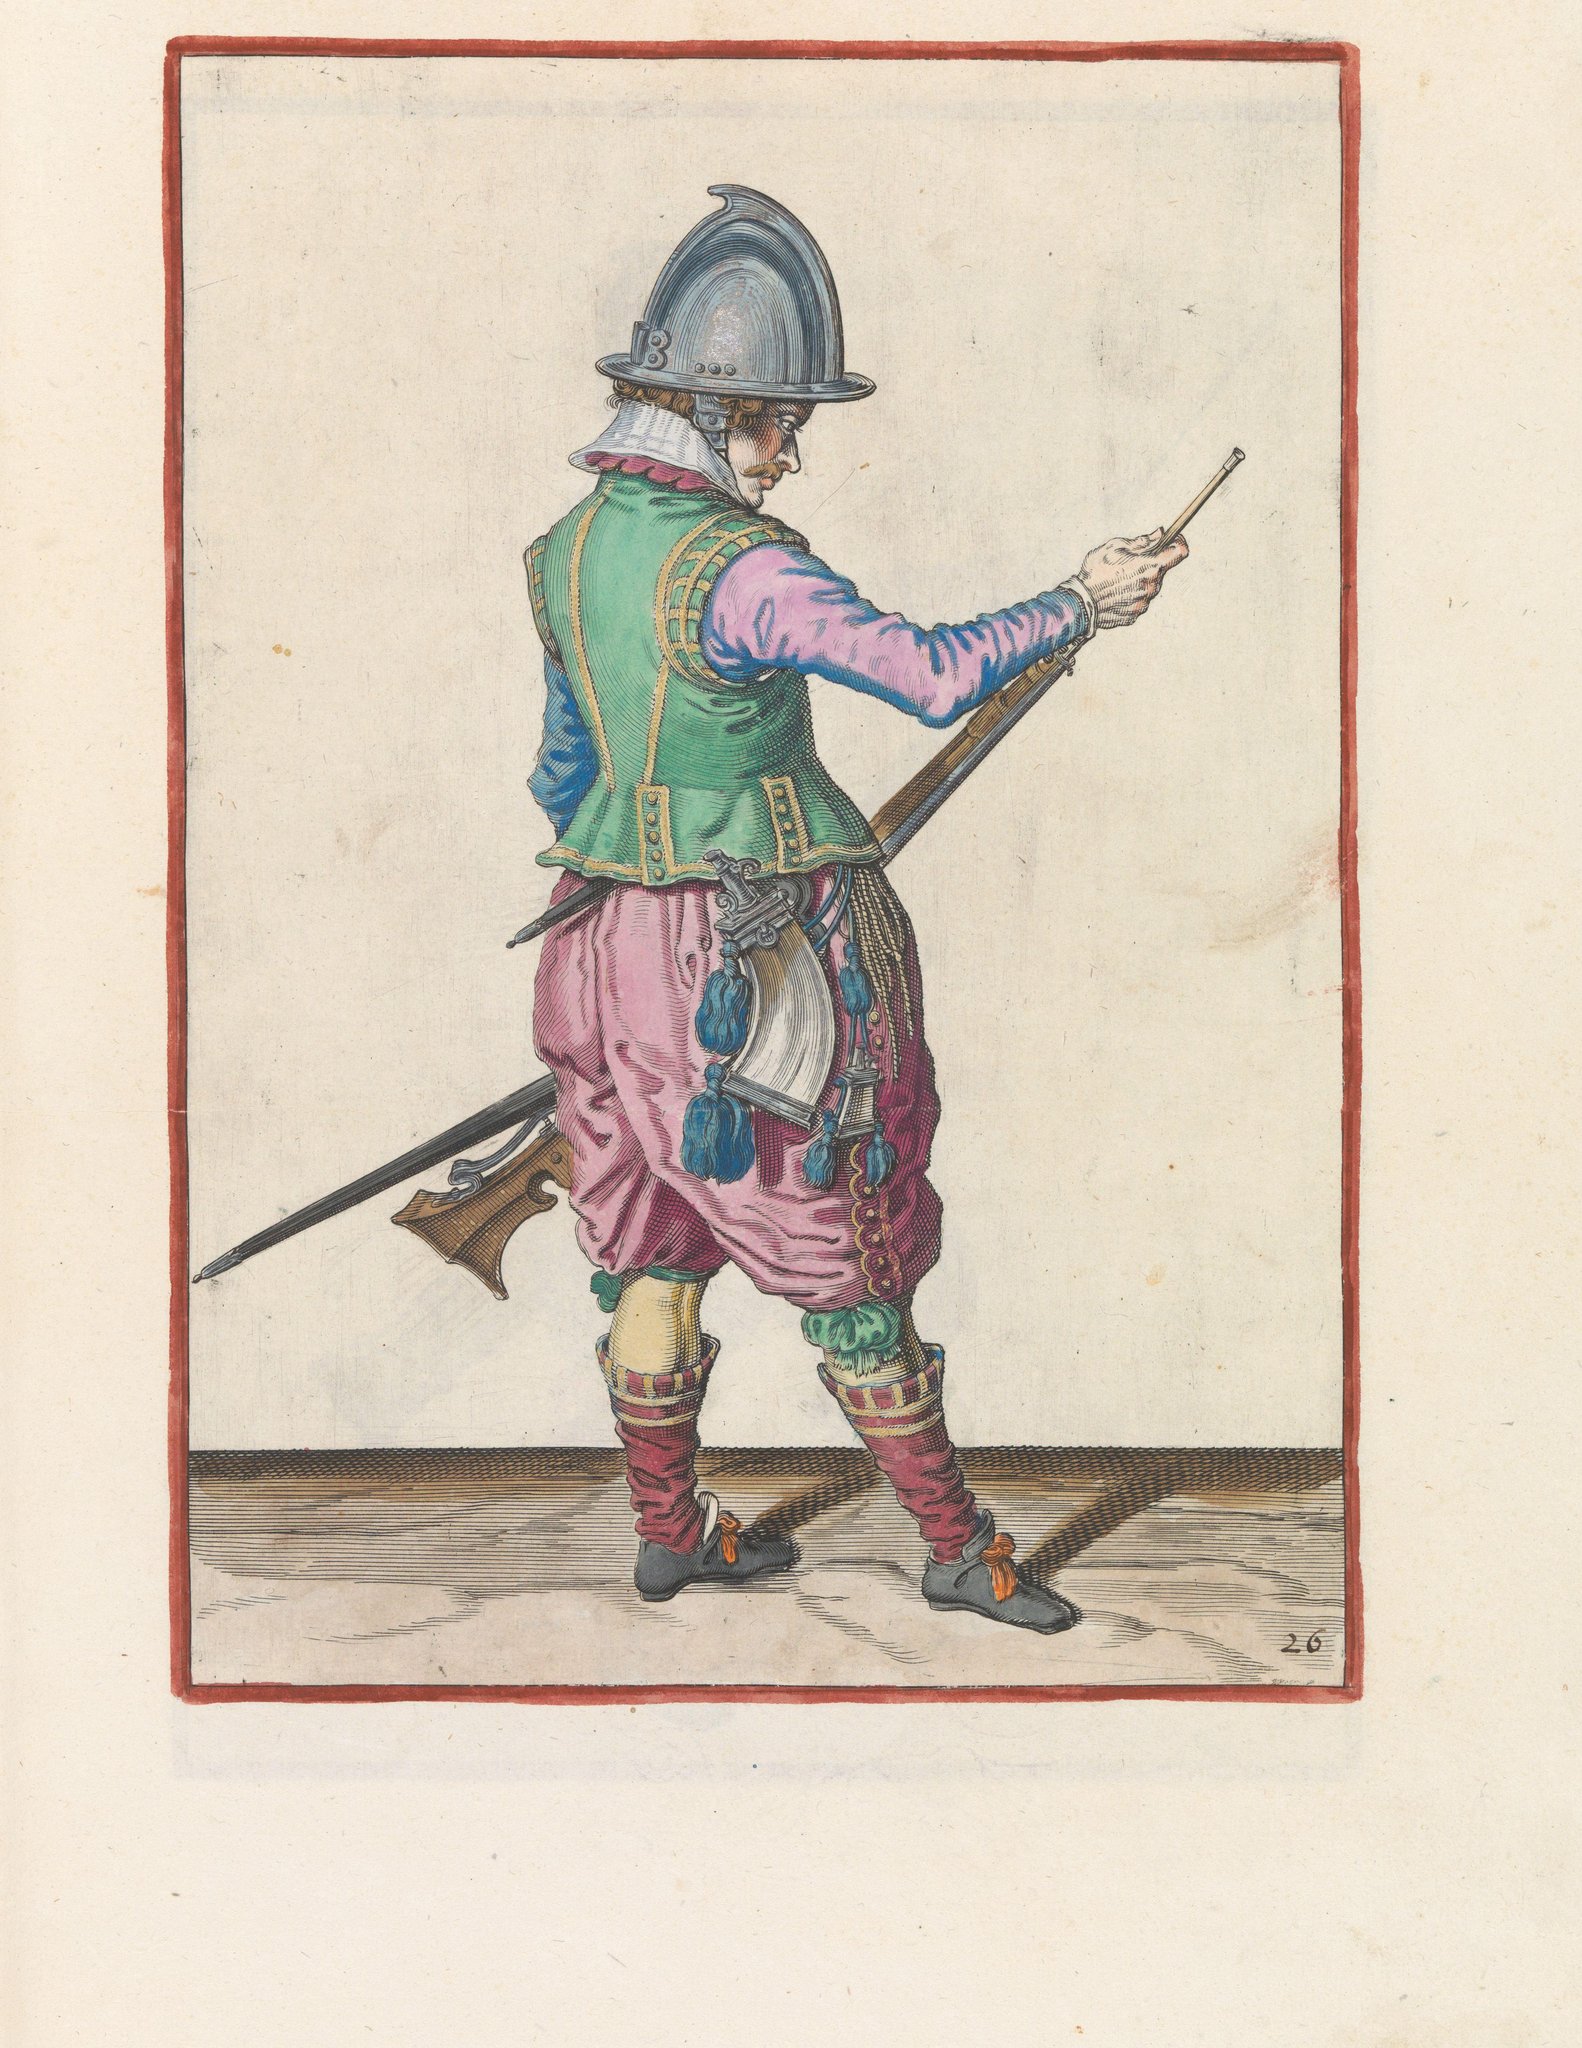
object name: print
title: Corte onderwysinghe op de figuerliicke afbeeldinghe, belanghende t'rechte ghebruyck des Roers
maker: jacques de gheyn (ii)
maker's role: painter, print maker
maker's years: 1565-1629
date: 1597-1607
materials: paper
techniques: engraving, hand coloring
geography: the hague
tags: handling of weapons ~ military training, firearms: rifle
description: Een soldaat, ten voeten uit, naar rechts, die met zijn linkerhand bij zijn linkerdijbeen een roer (een bepaald type vuurwapen) vasthoudt en met zijn rechterhand zijn laadstok in de loop brengt, om kruit en kogel aan te duwen. Deze prent is onderdeel van de reeks van 42 met de hand genummerde prenten van roerschutters in de Wapenhandelinghe.